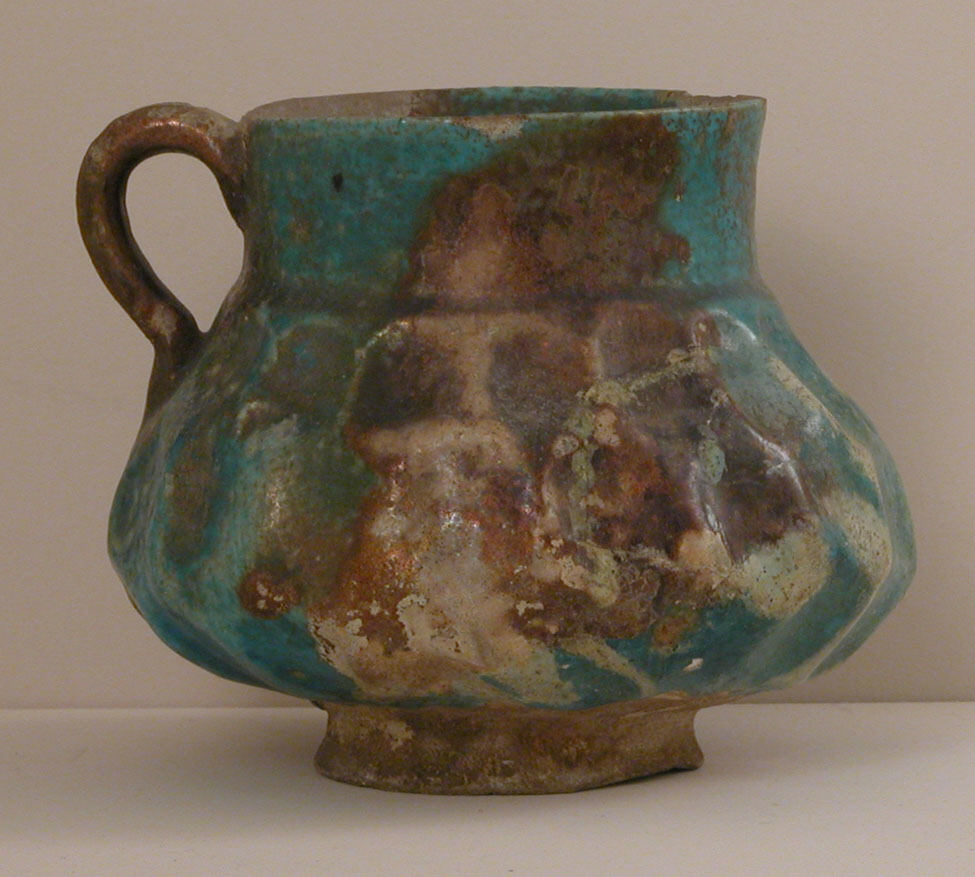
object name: ewer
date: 1101-1300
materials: glaze, stonepaste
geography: syria